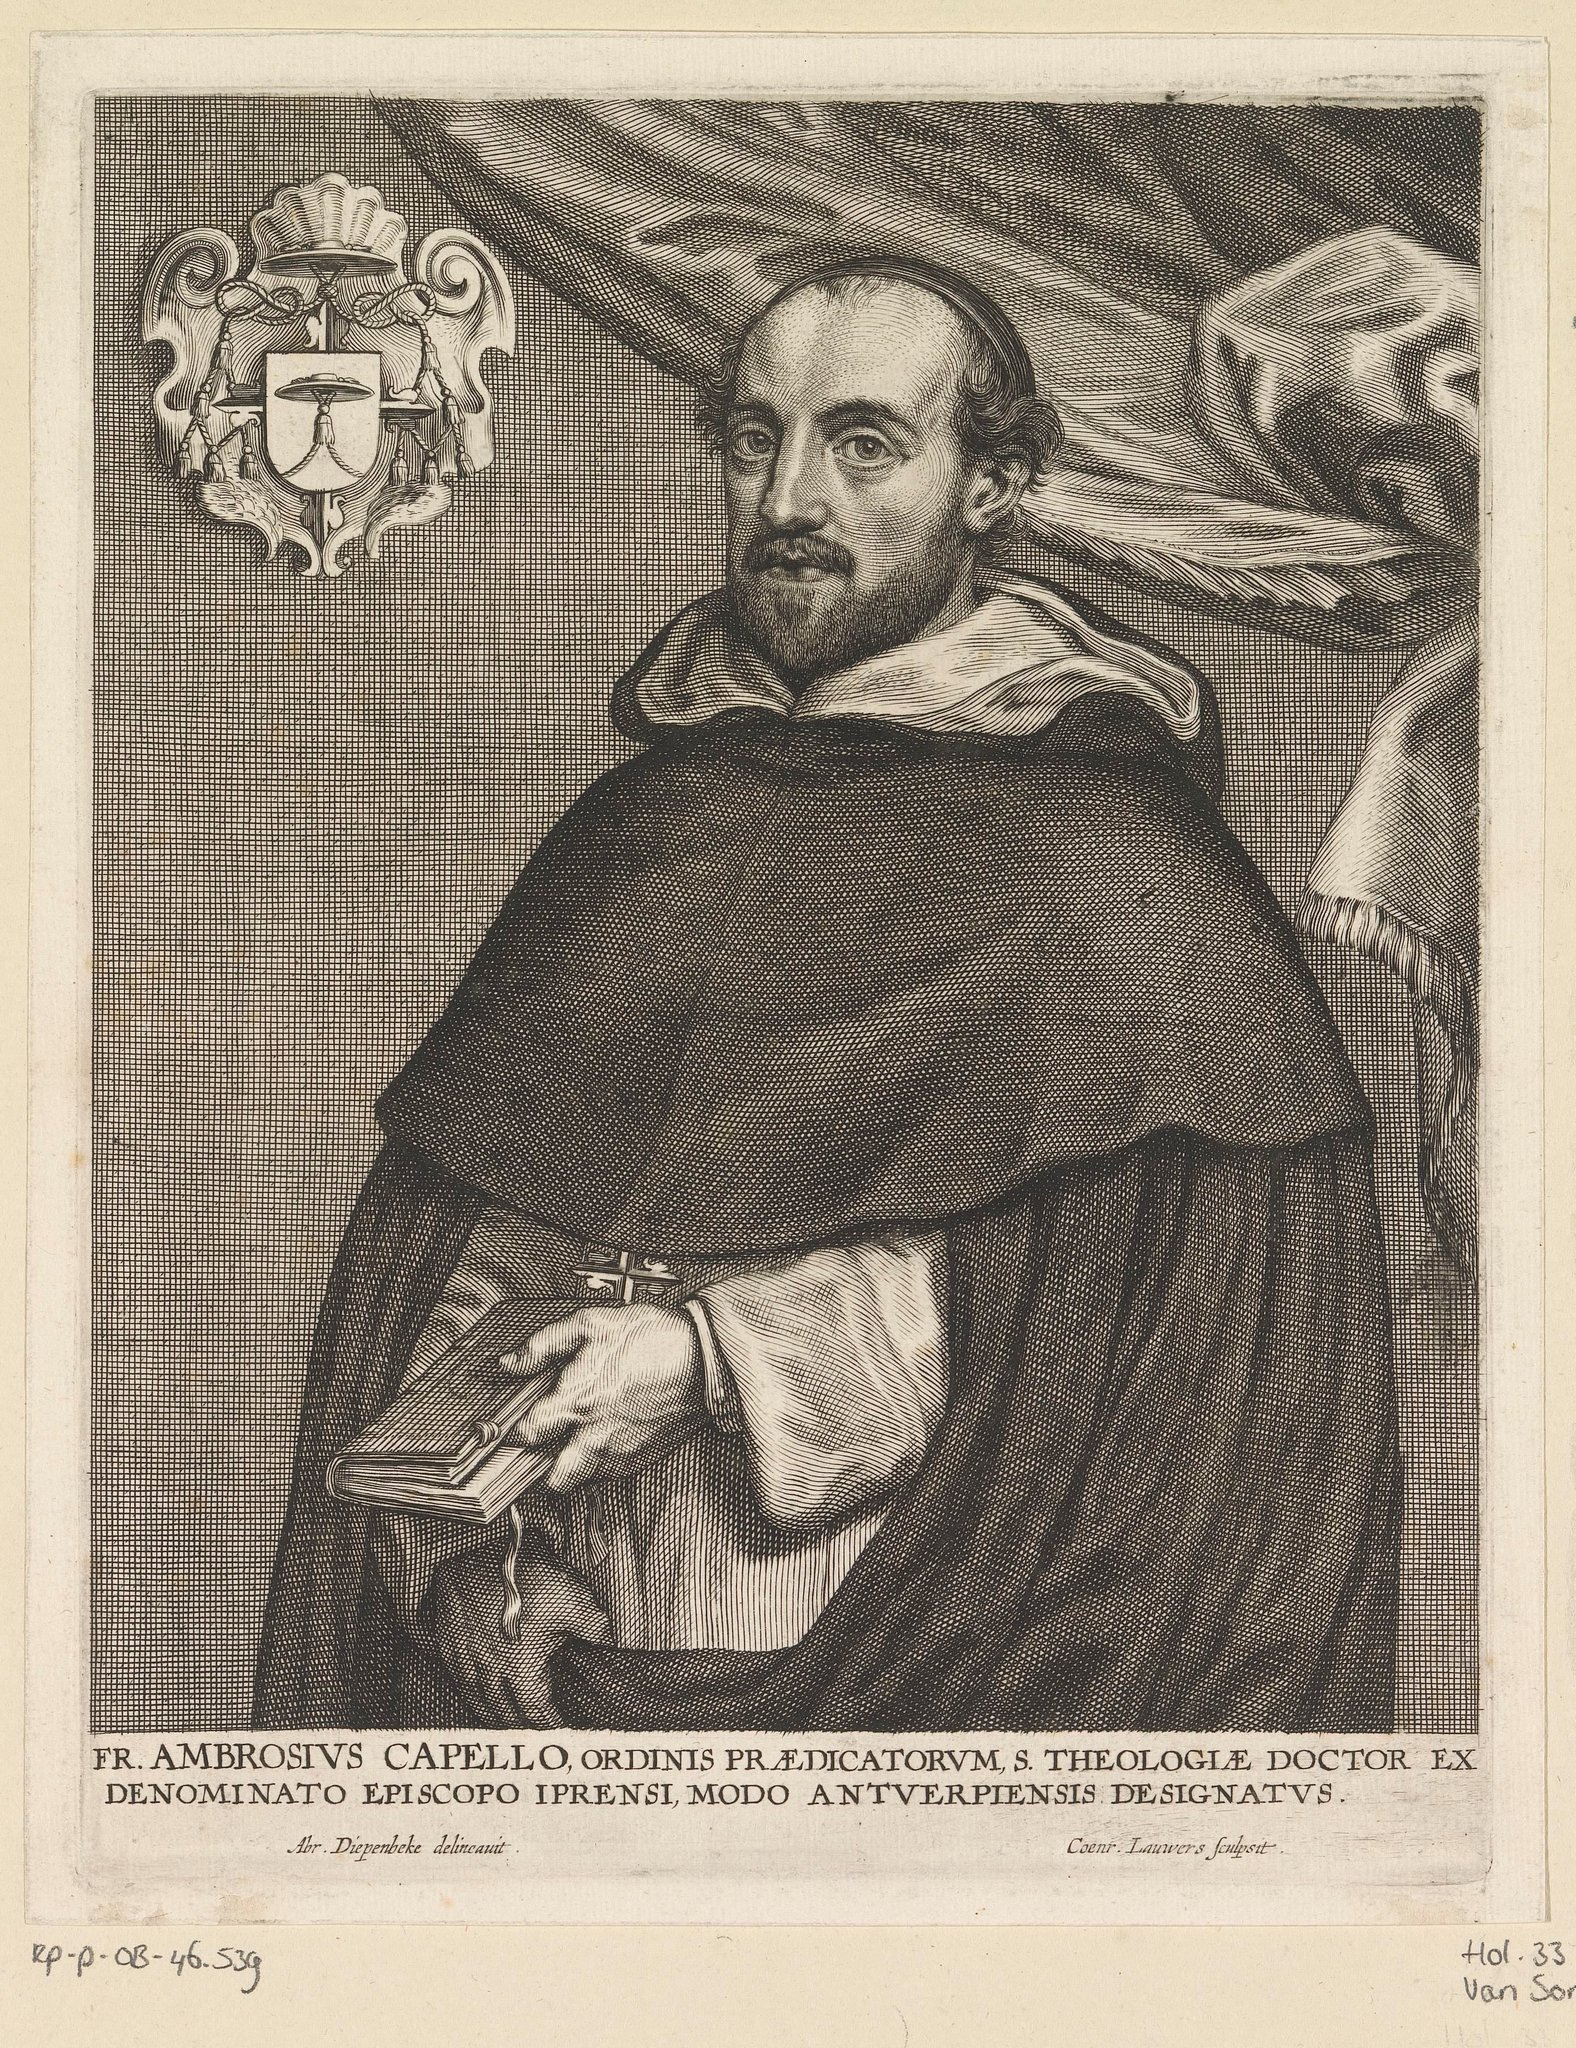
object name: print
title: Portret van Marius Ambrosius Capello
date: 1642-1685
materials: paper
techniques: engraving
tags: antwerp, marius ambrosius capello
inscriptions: collector's mark: Lugt 240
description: Portret ten halven lijve naar links van bisschop Marius Ambrosius Capello, met kalot. In zijn hand houdt Capello een bijbel vast, zijn familiewapen prijkt in de linker bovenhoek. In de marge staat een tweeregelig onderschrift in Latijn.